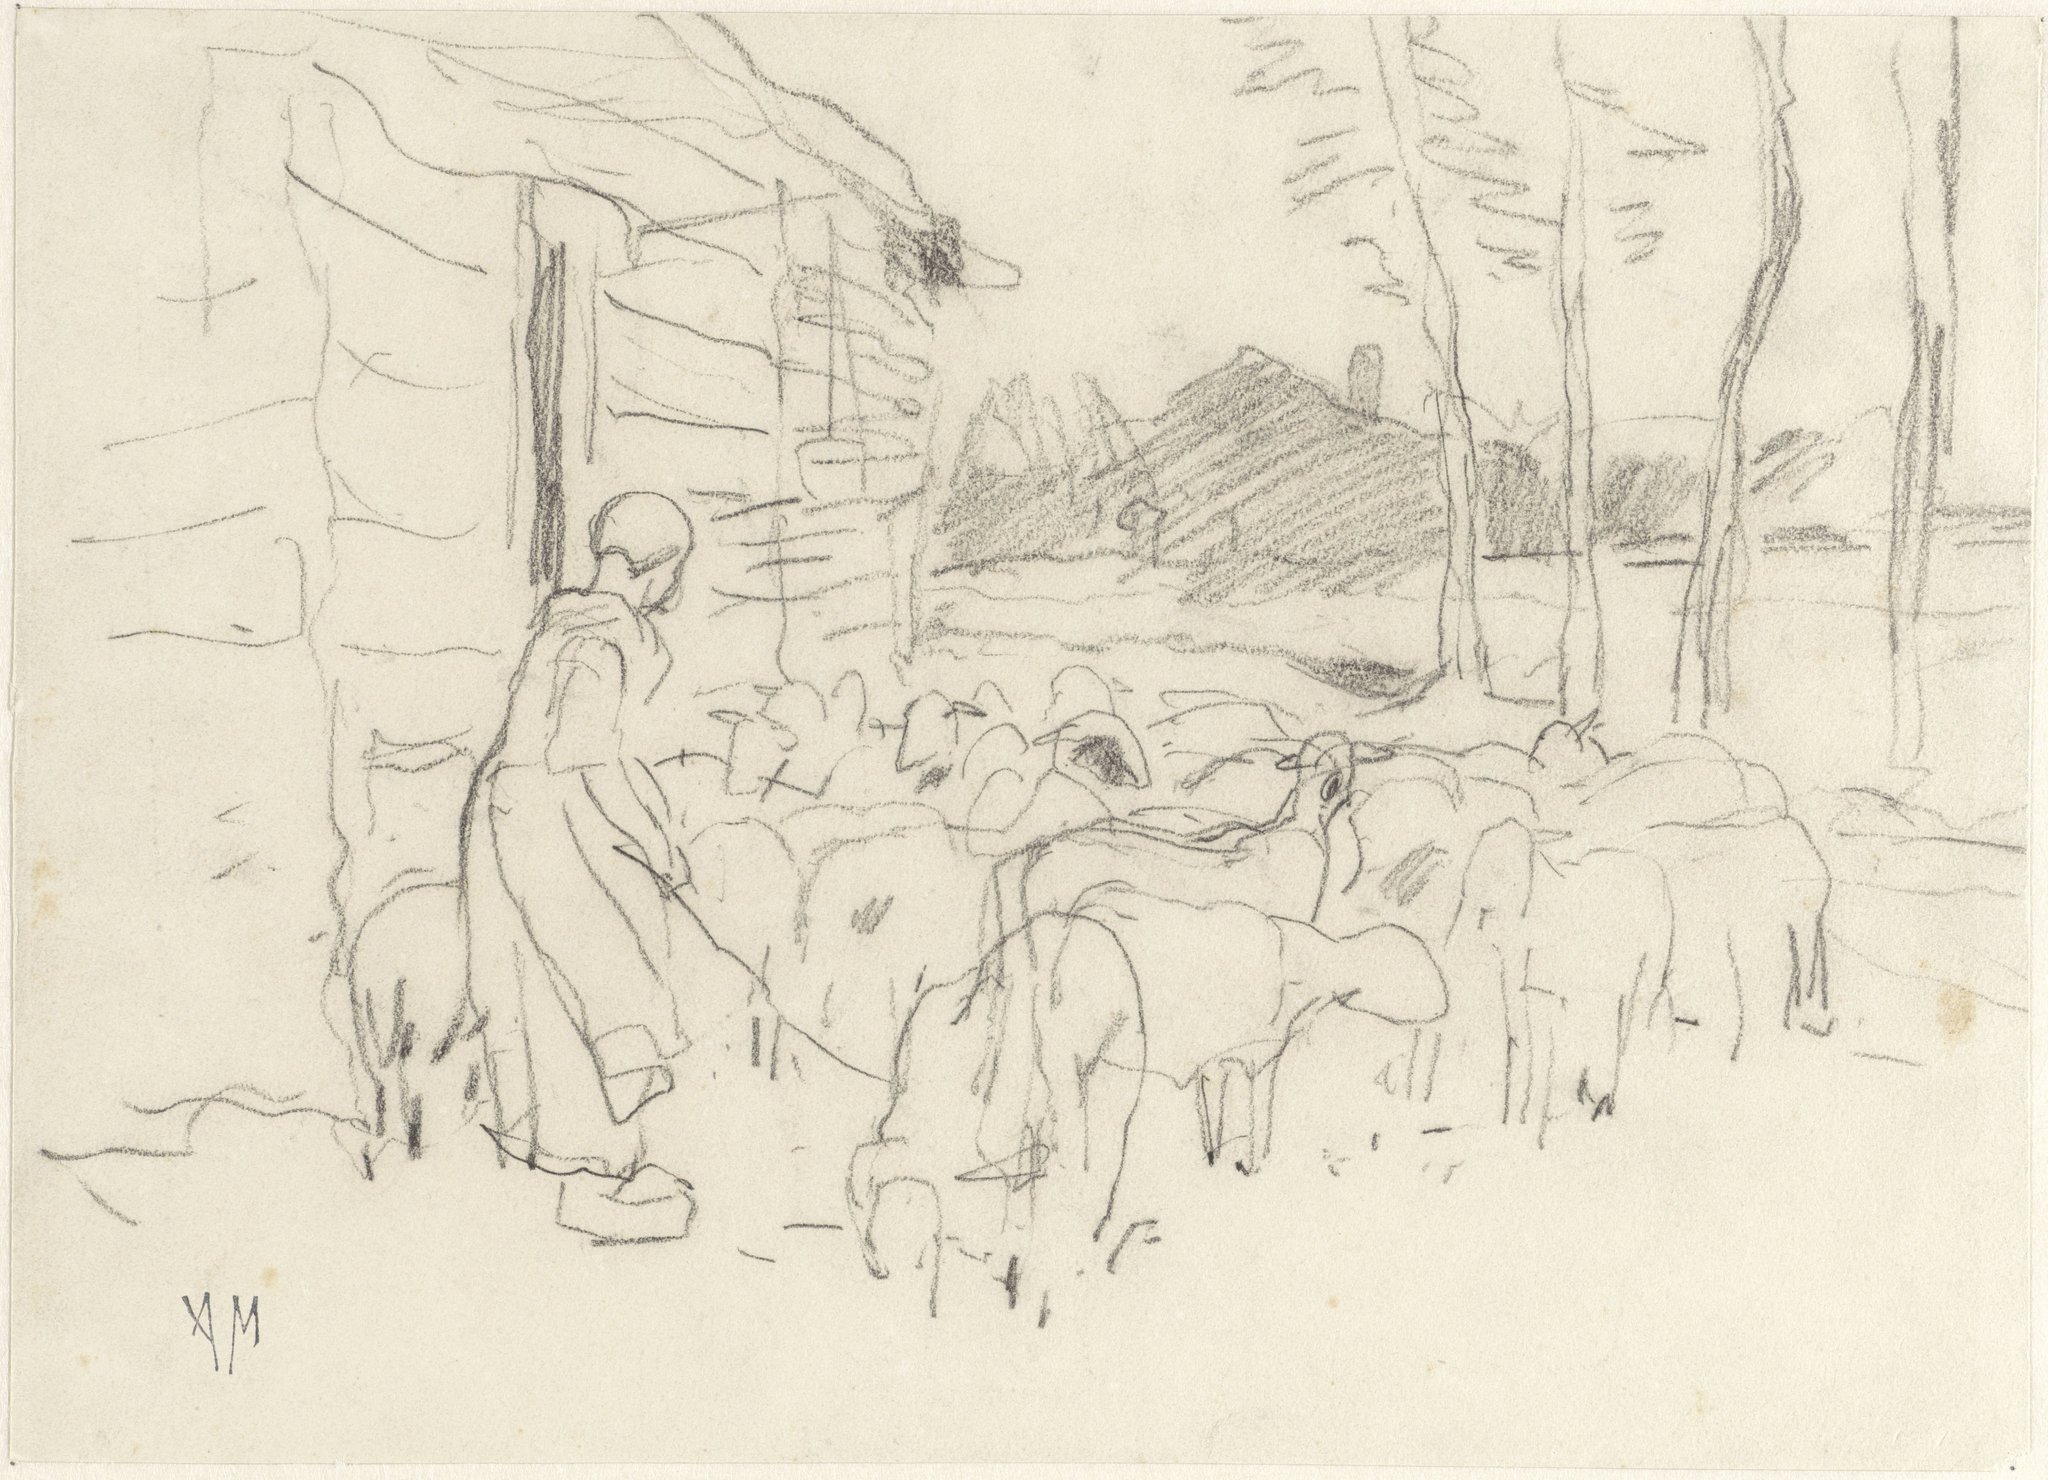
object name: drawing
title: Schaapherderin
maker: anton mauve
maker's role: draughtsman, painter, print maker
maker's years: 1838-1888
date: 1848-1888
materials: chalk, paper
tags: sheep, herd, flock